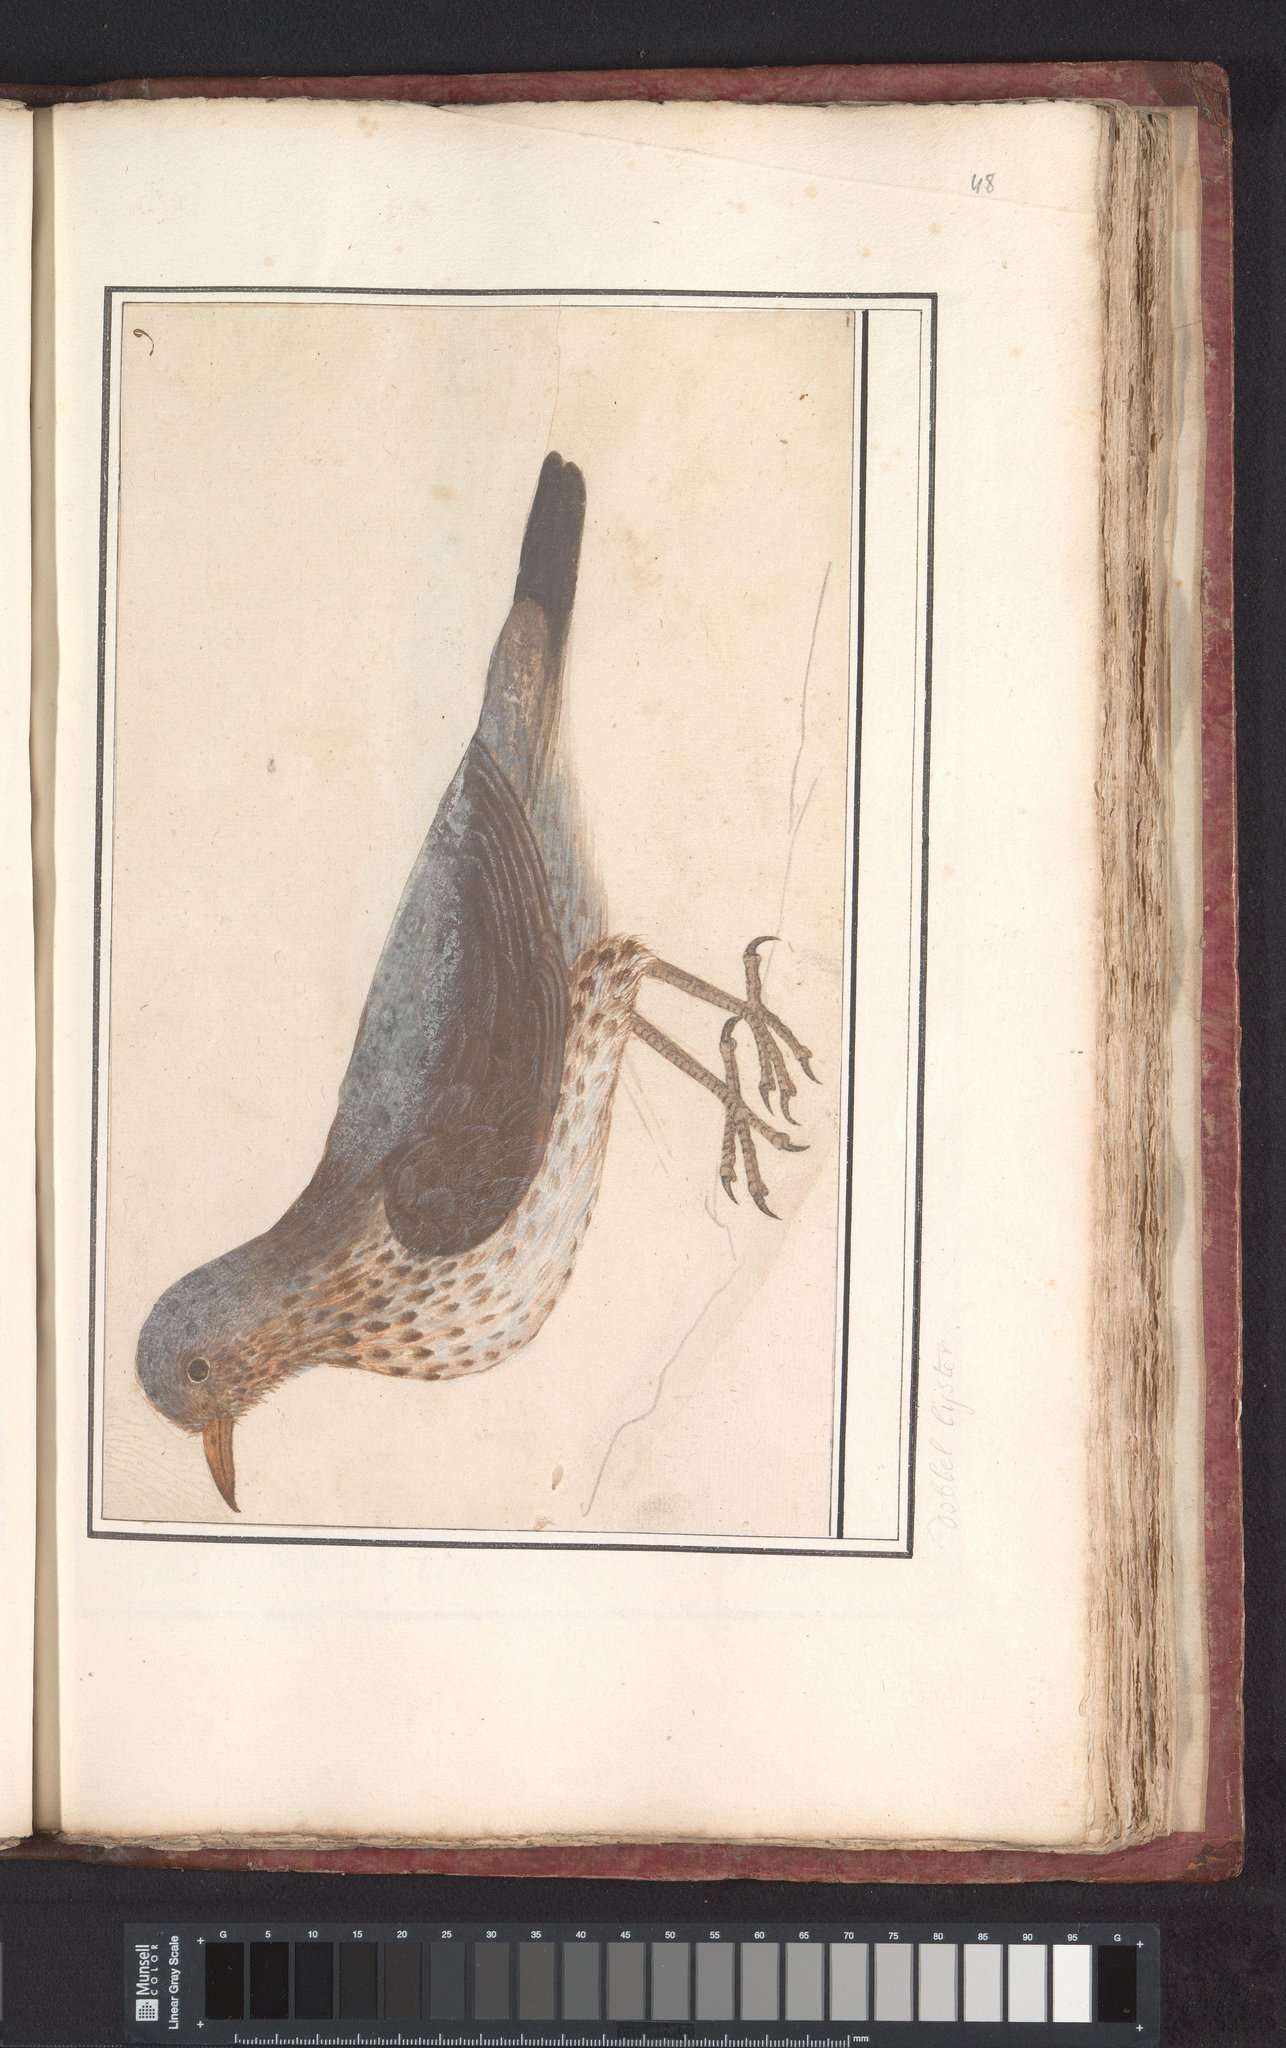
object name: drawing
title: Kramsvogel (Turdus pilaris)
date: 1596-1610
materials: chalk, paint, paper, pencil, watercolor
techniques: brush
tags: song-birds: fieldfare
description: Kramsvogel. Genummerd rechtsboven: 9. Onderdeel van het derde album met tekeningen van vogels. Vijfde van twaalf albums met tekeningen van dieren, vogels en planten bekend rond 1600, gemaakt in opdracht van keizer Rudolf II. Met toelichting in Nederlands, Latijn en Frans.